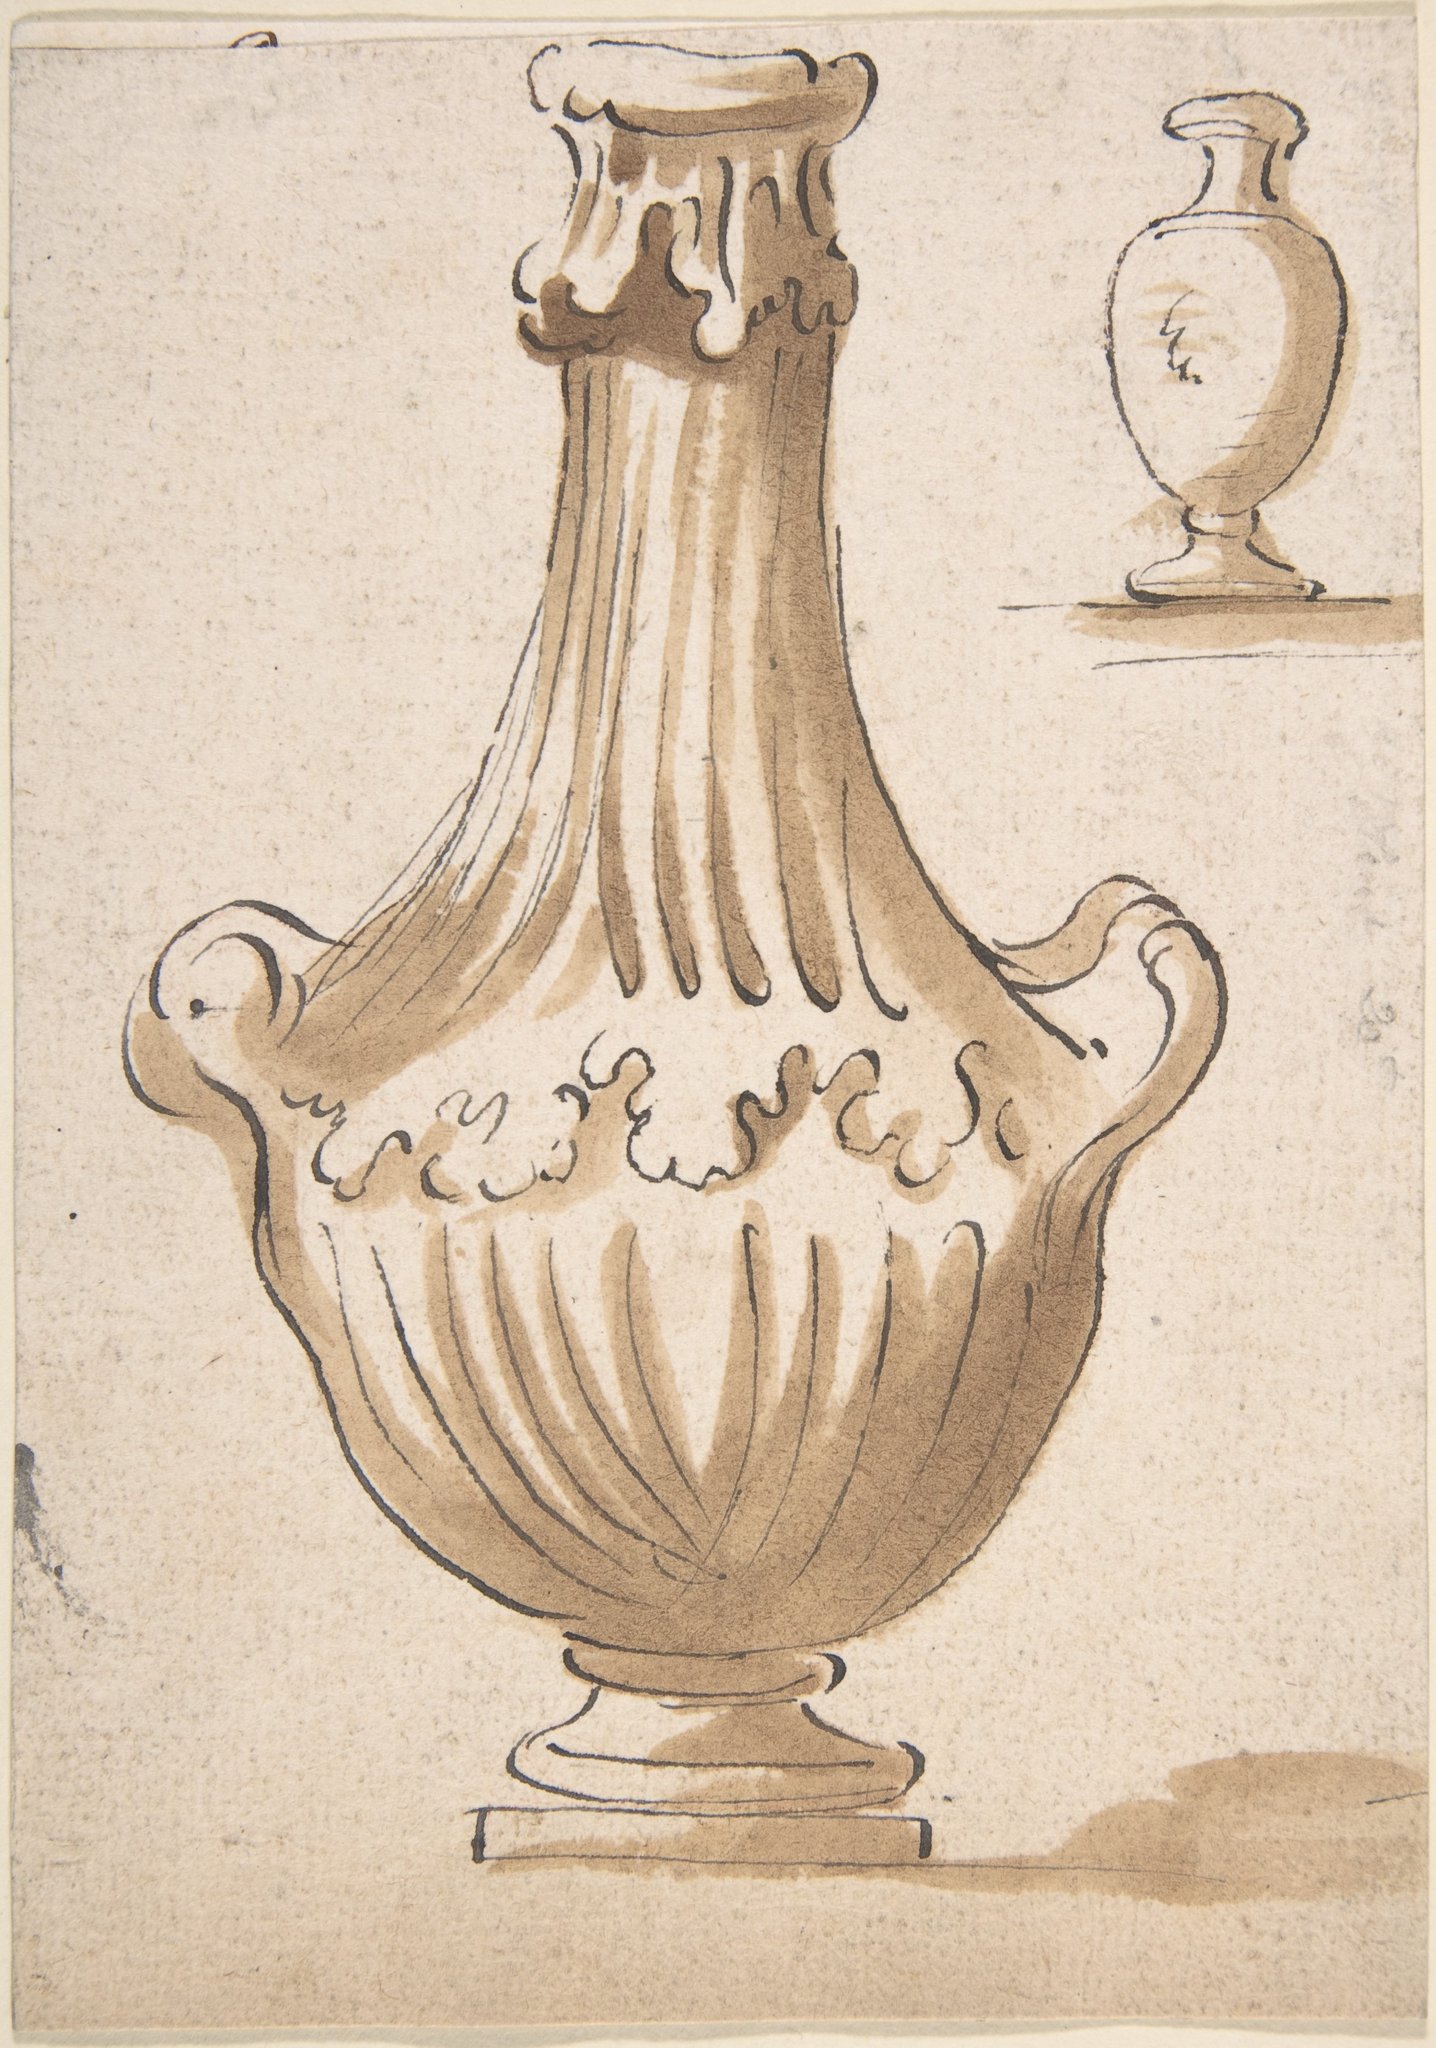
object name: drawing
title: Design for a Vase: two handles, no cover. In upper right corner, a smaller, simpler shape (recto); Part of a Chalk Drawing (verso)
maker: anonymous, italian, venetian, 18th century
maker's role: artist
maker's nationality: italian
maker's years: 1700-1800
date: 1701-1800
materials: chalk, ink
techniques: brush, pen, wash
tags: vases